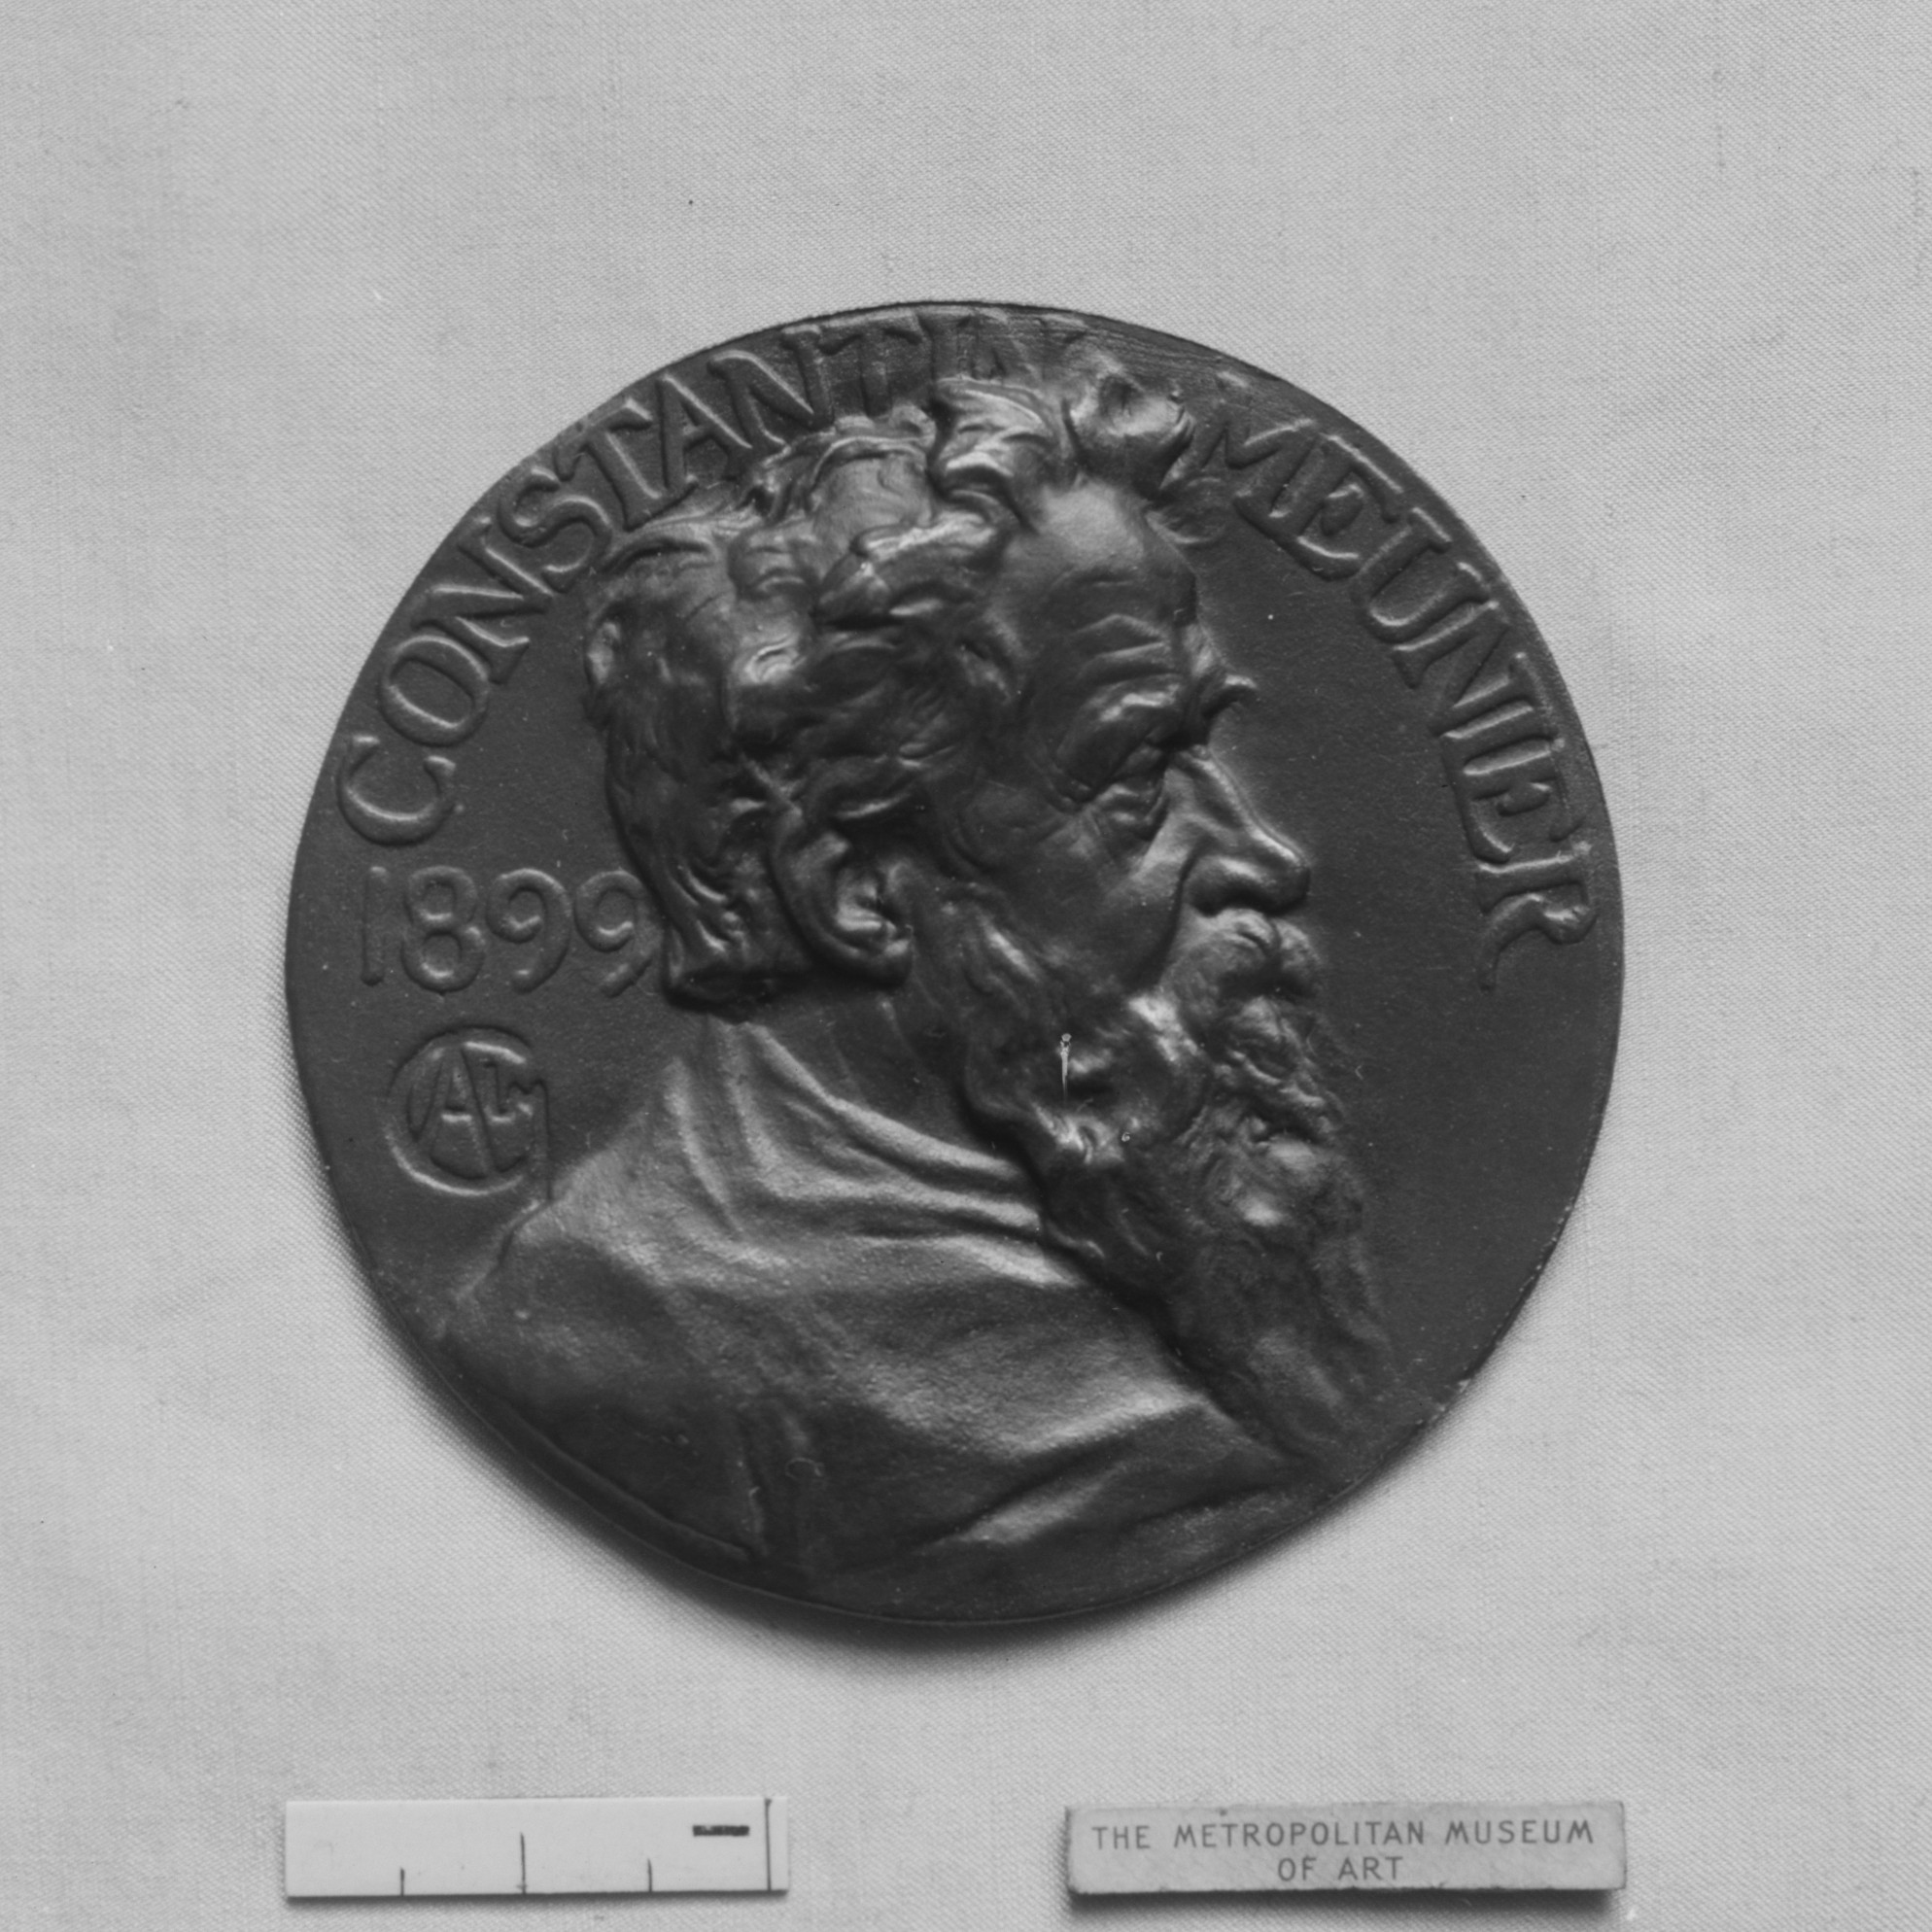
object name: medal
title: Portrait of Constantin Meunier, Belgian painter and sculptor (1831–1905)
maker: alexandre-louis-marie charpentier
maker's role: artist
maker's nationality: french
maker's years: 1856-1909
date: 1867-1900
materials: bronze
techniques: casting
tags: men,profiles